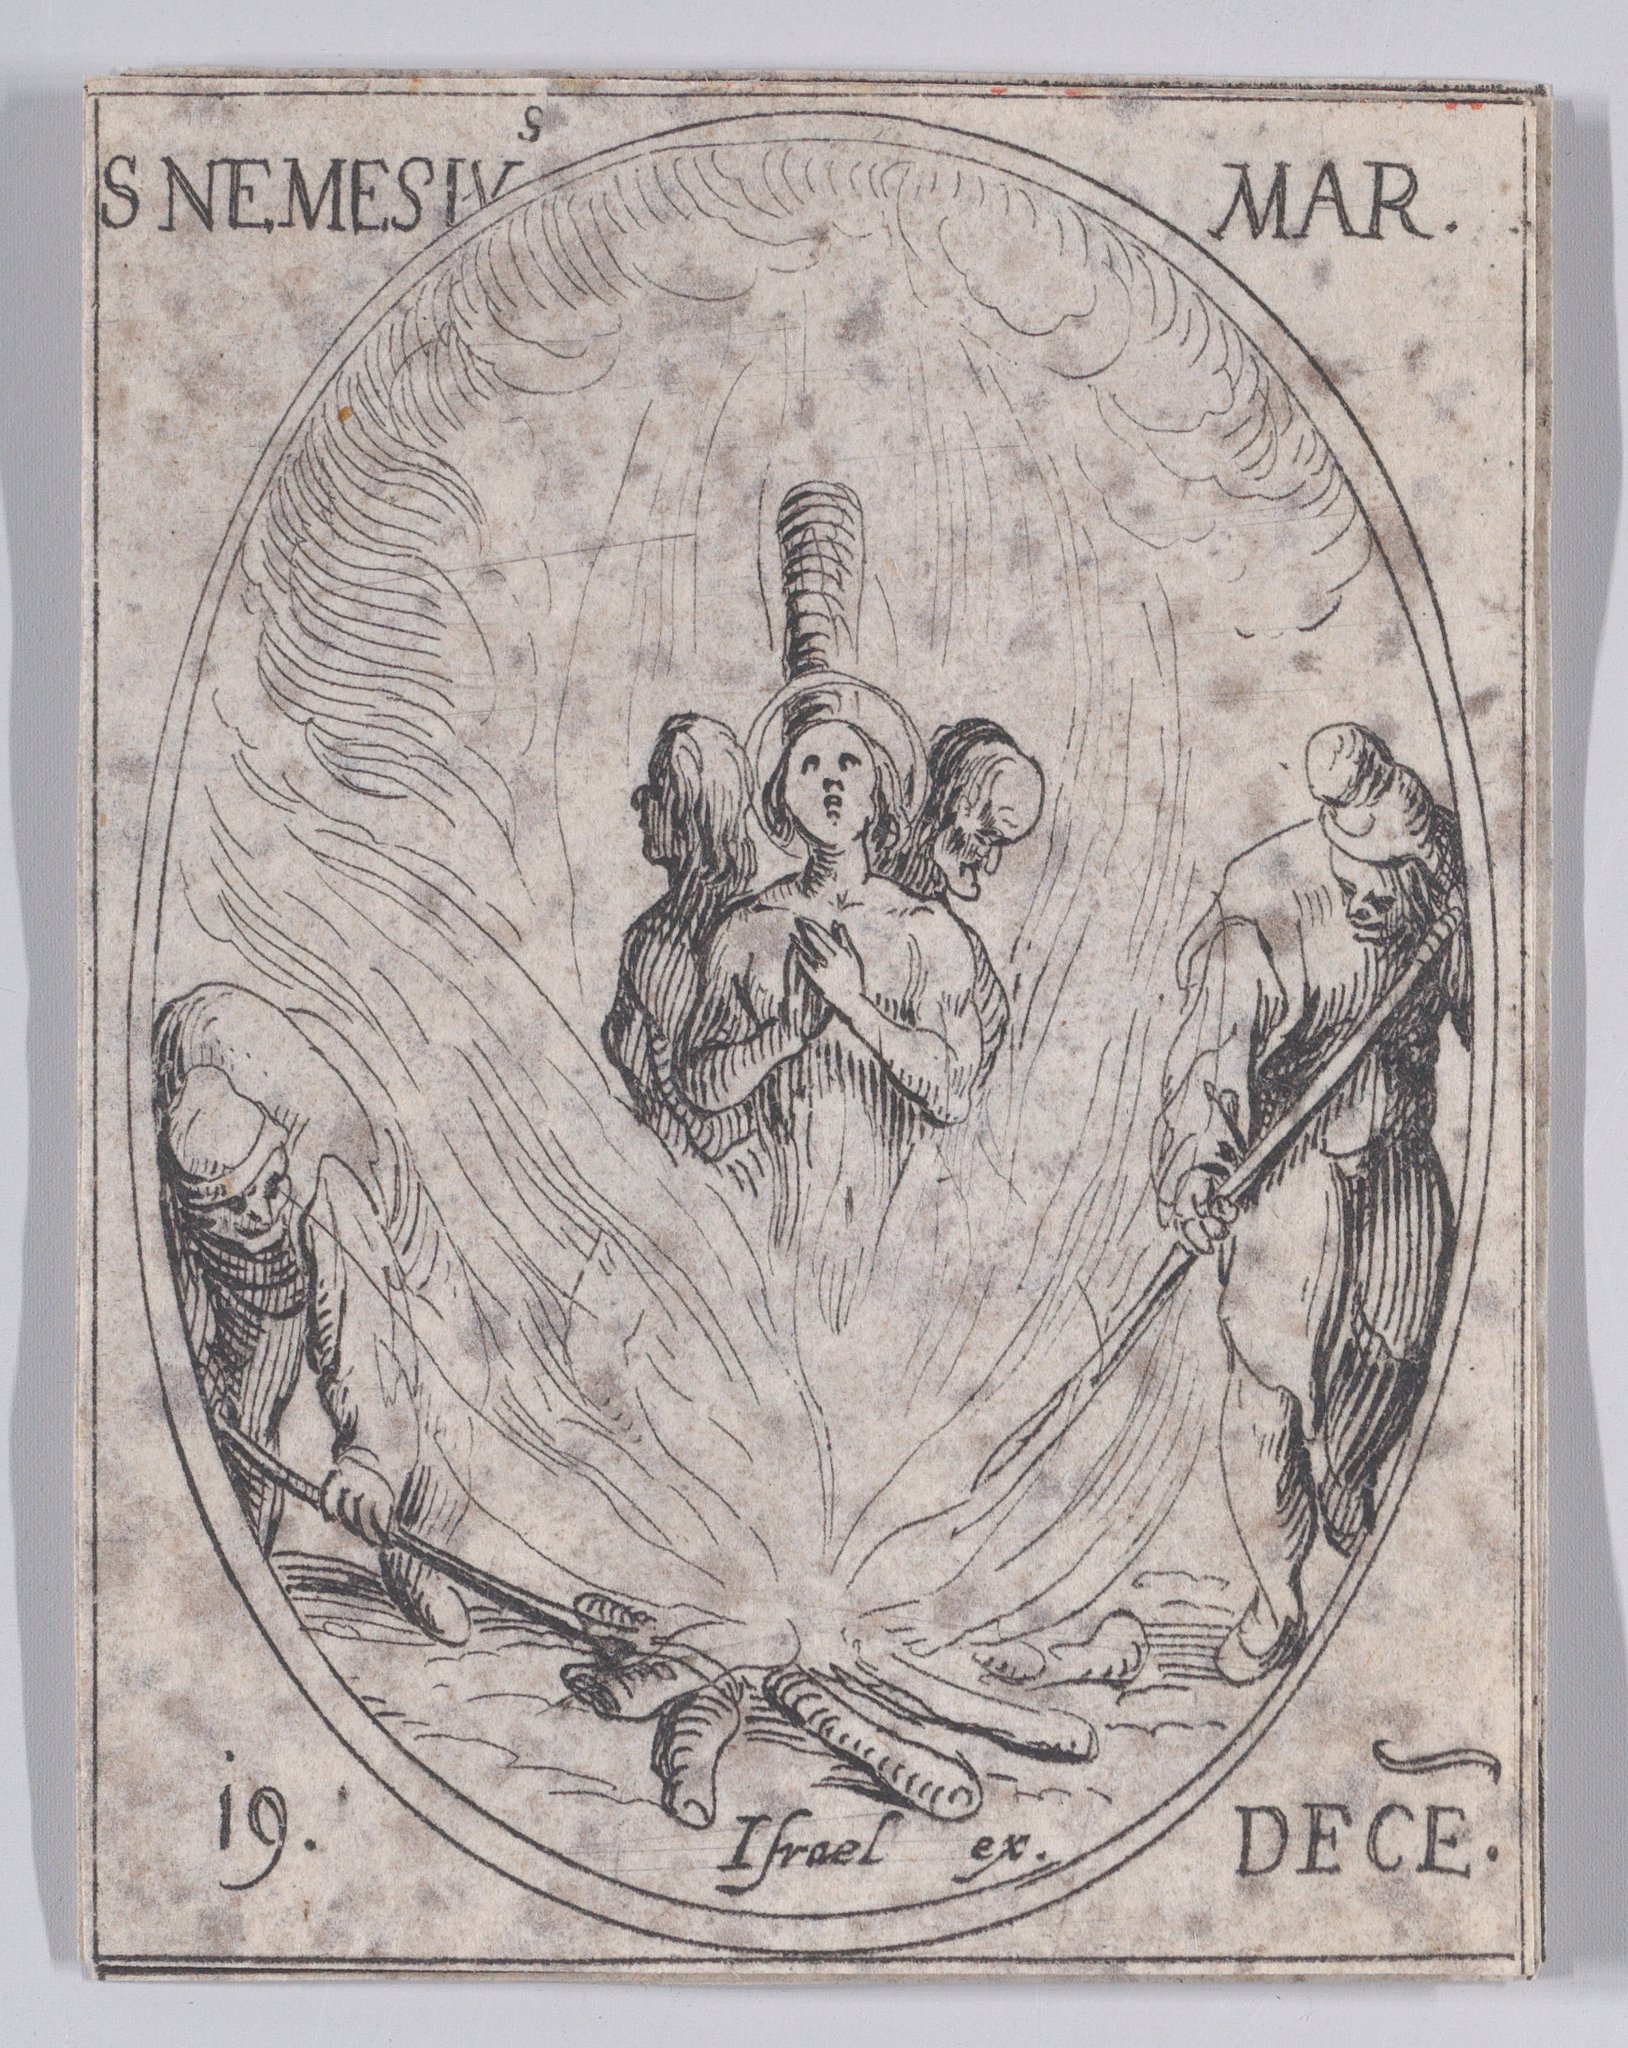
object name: print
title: S. Nemèse, martyr (St. Nemesius, Martyr), December 19th, from "Les Images De Tous Les Saincts et Saintes de L'Année" (Images of All of the Saints and Religious Events of the Year)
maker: jacques callot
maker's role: artist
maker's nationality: french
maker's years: 1592-1635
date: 1636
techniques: etching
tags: men,fire,saints